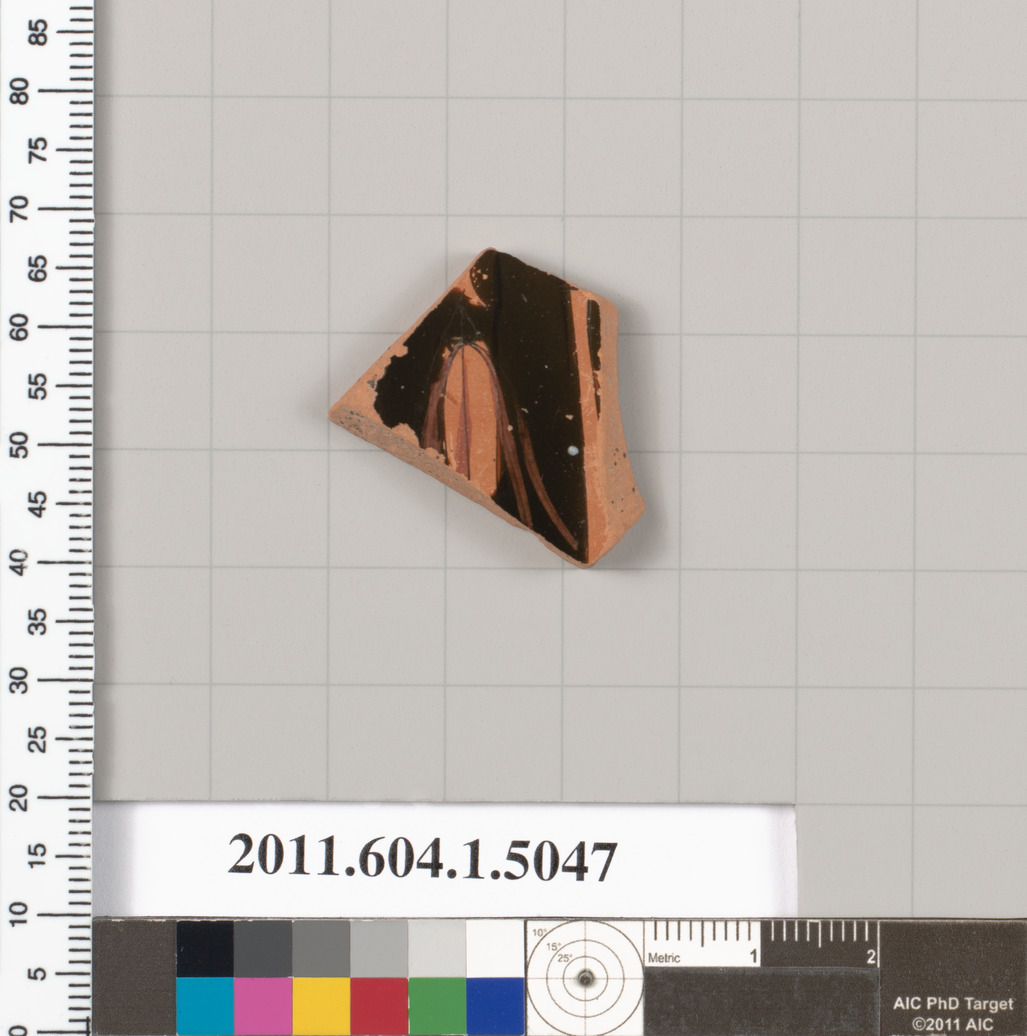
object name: kylix fragment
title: Terracotta fragment of a kylix (drinking cup)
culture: greek, attic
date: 500-476 BCE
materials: terracotta